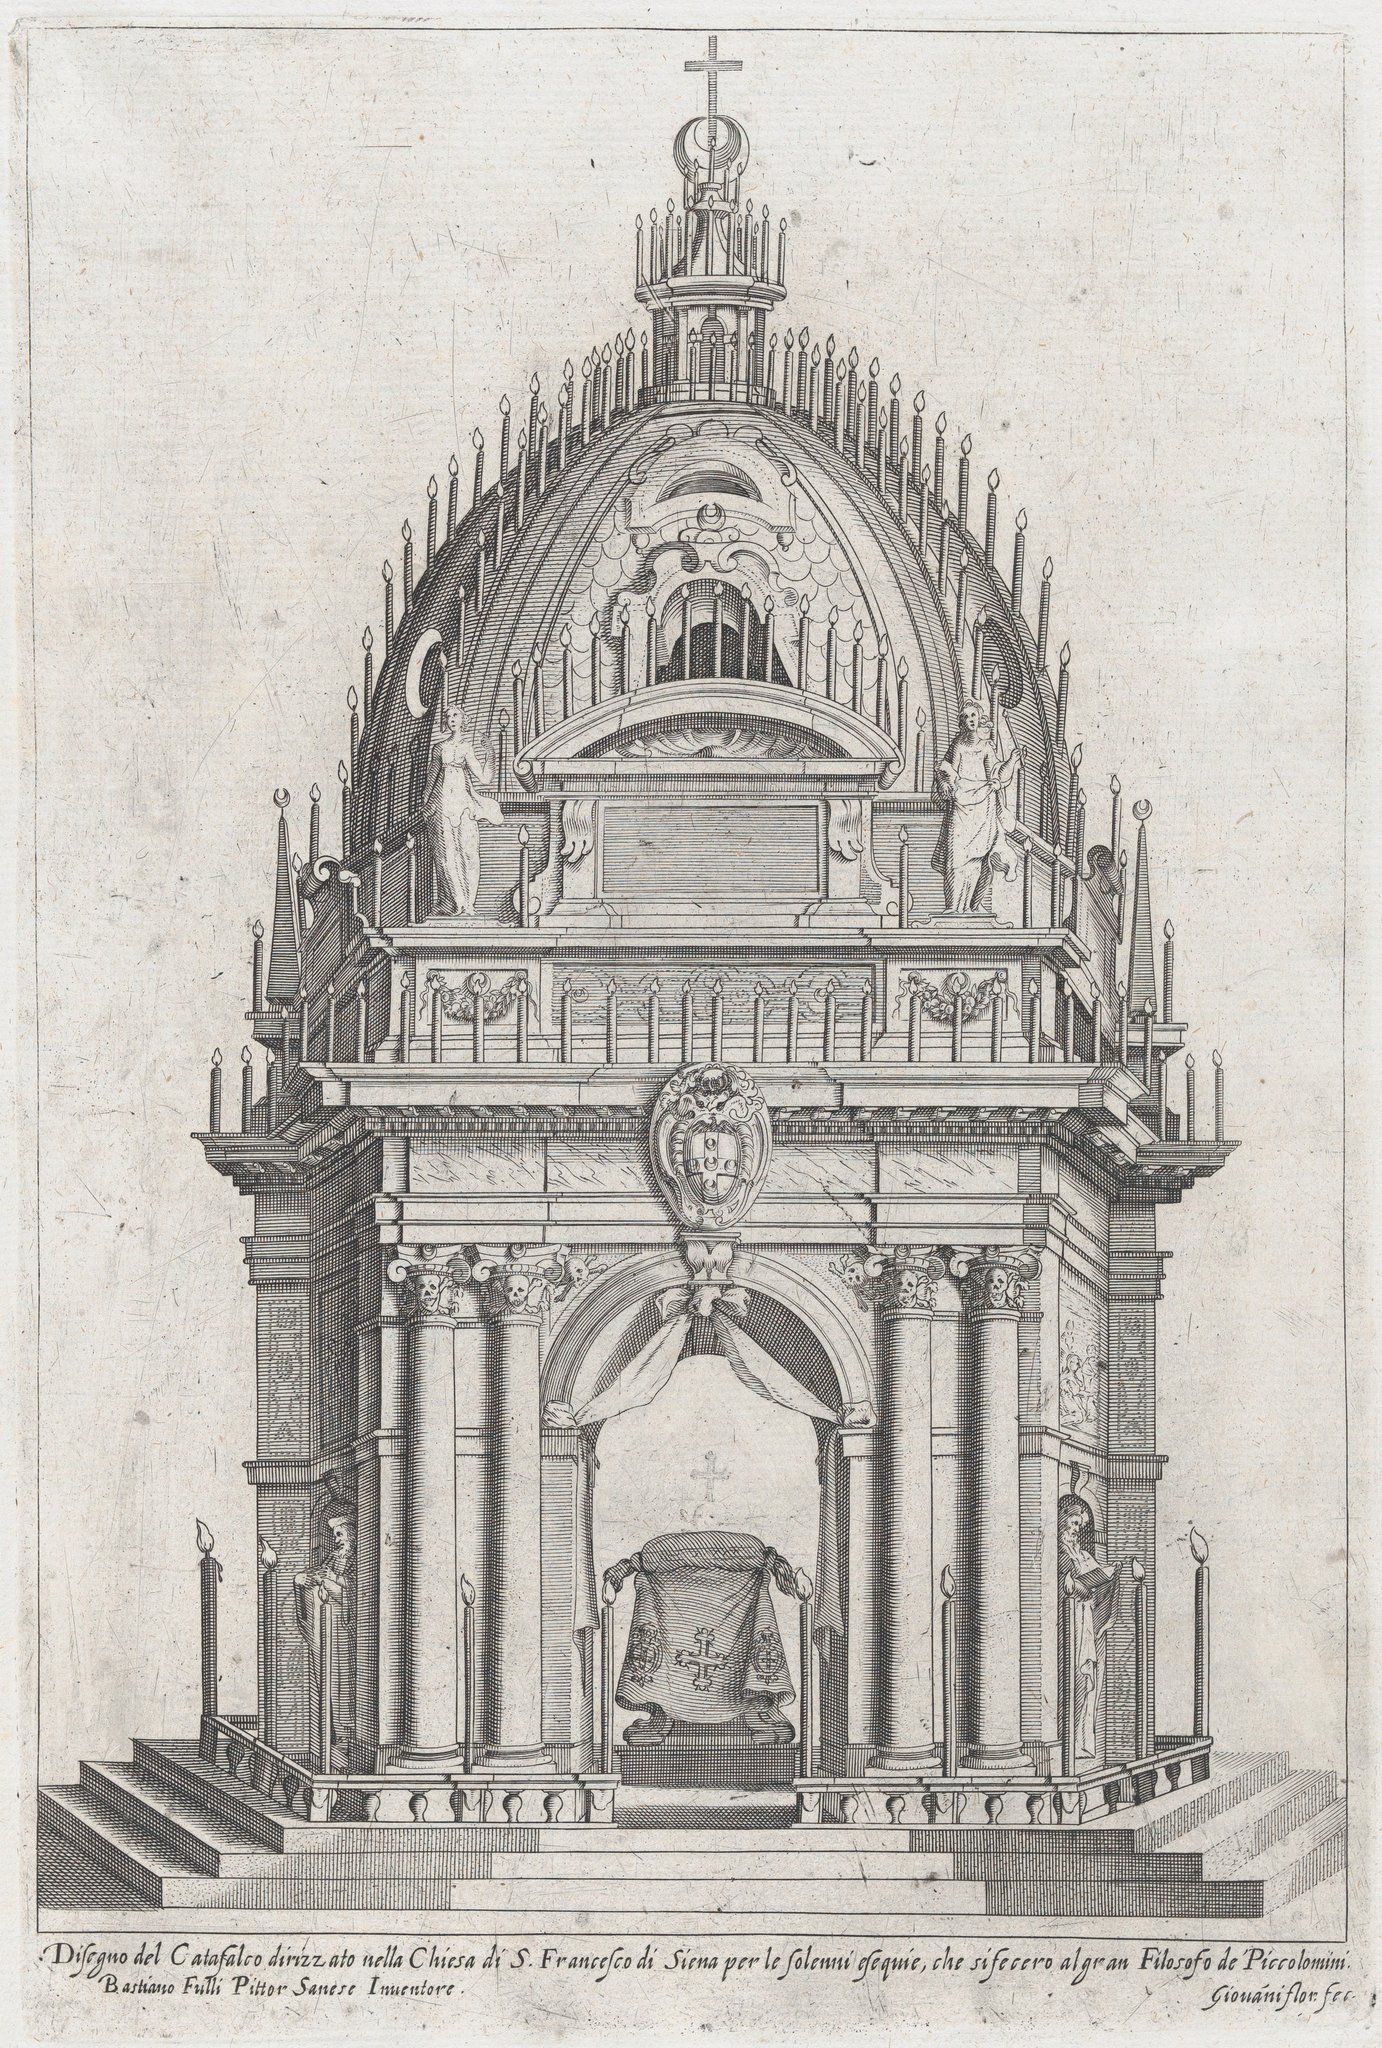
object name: print, fete, ornament architecture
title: Design of the catafalque for Francesco Piccolomini; from 'Libro De Catafalchi, Tabernacoli, con varij designi di Porte fenestre et altri ornamenti di Architettura'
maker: giovanni florimi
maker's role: artist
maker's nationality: italian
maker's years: 1600-1635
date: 1607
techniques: engraving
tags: architecture,candles